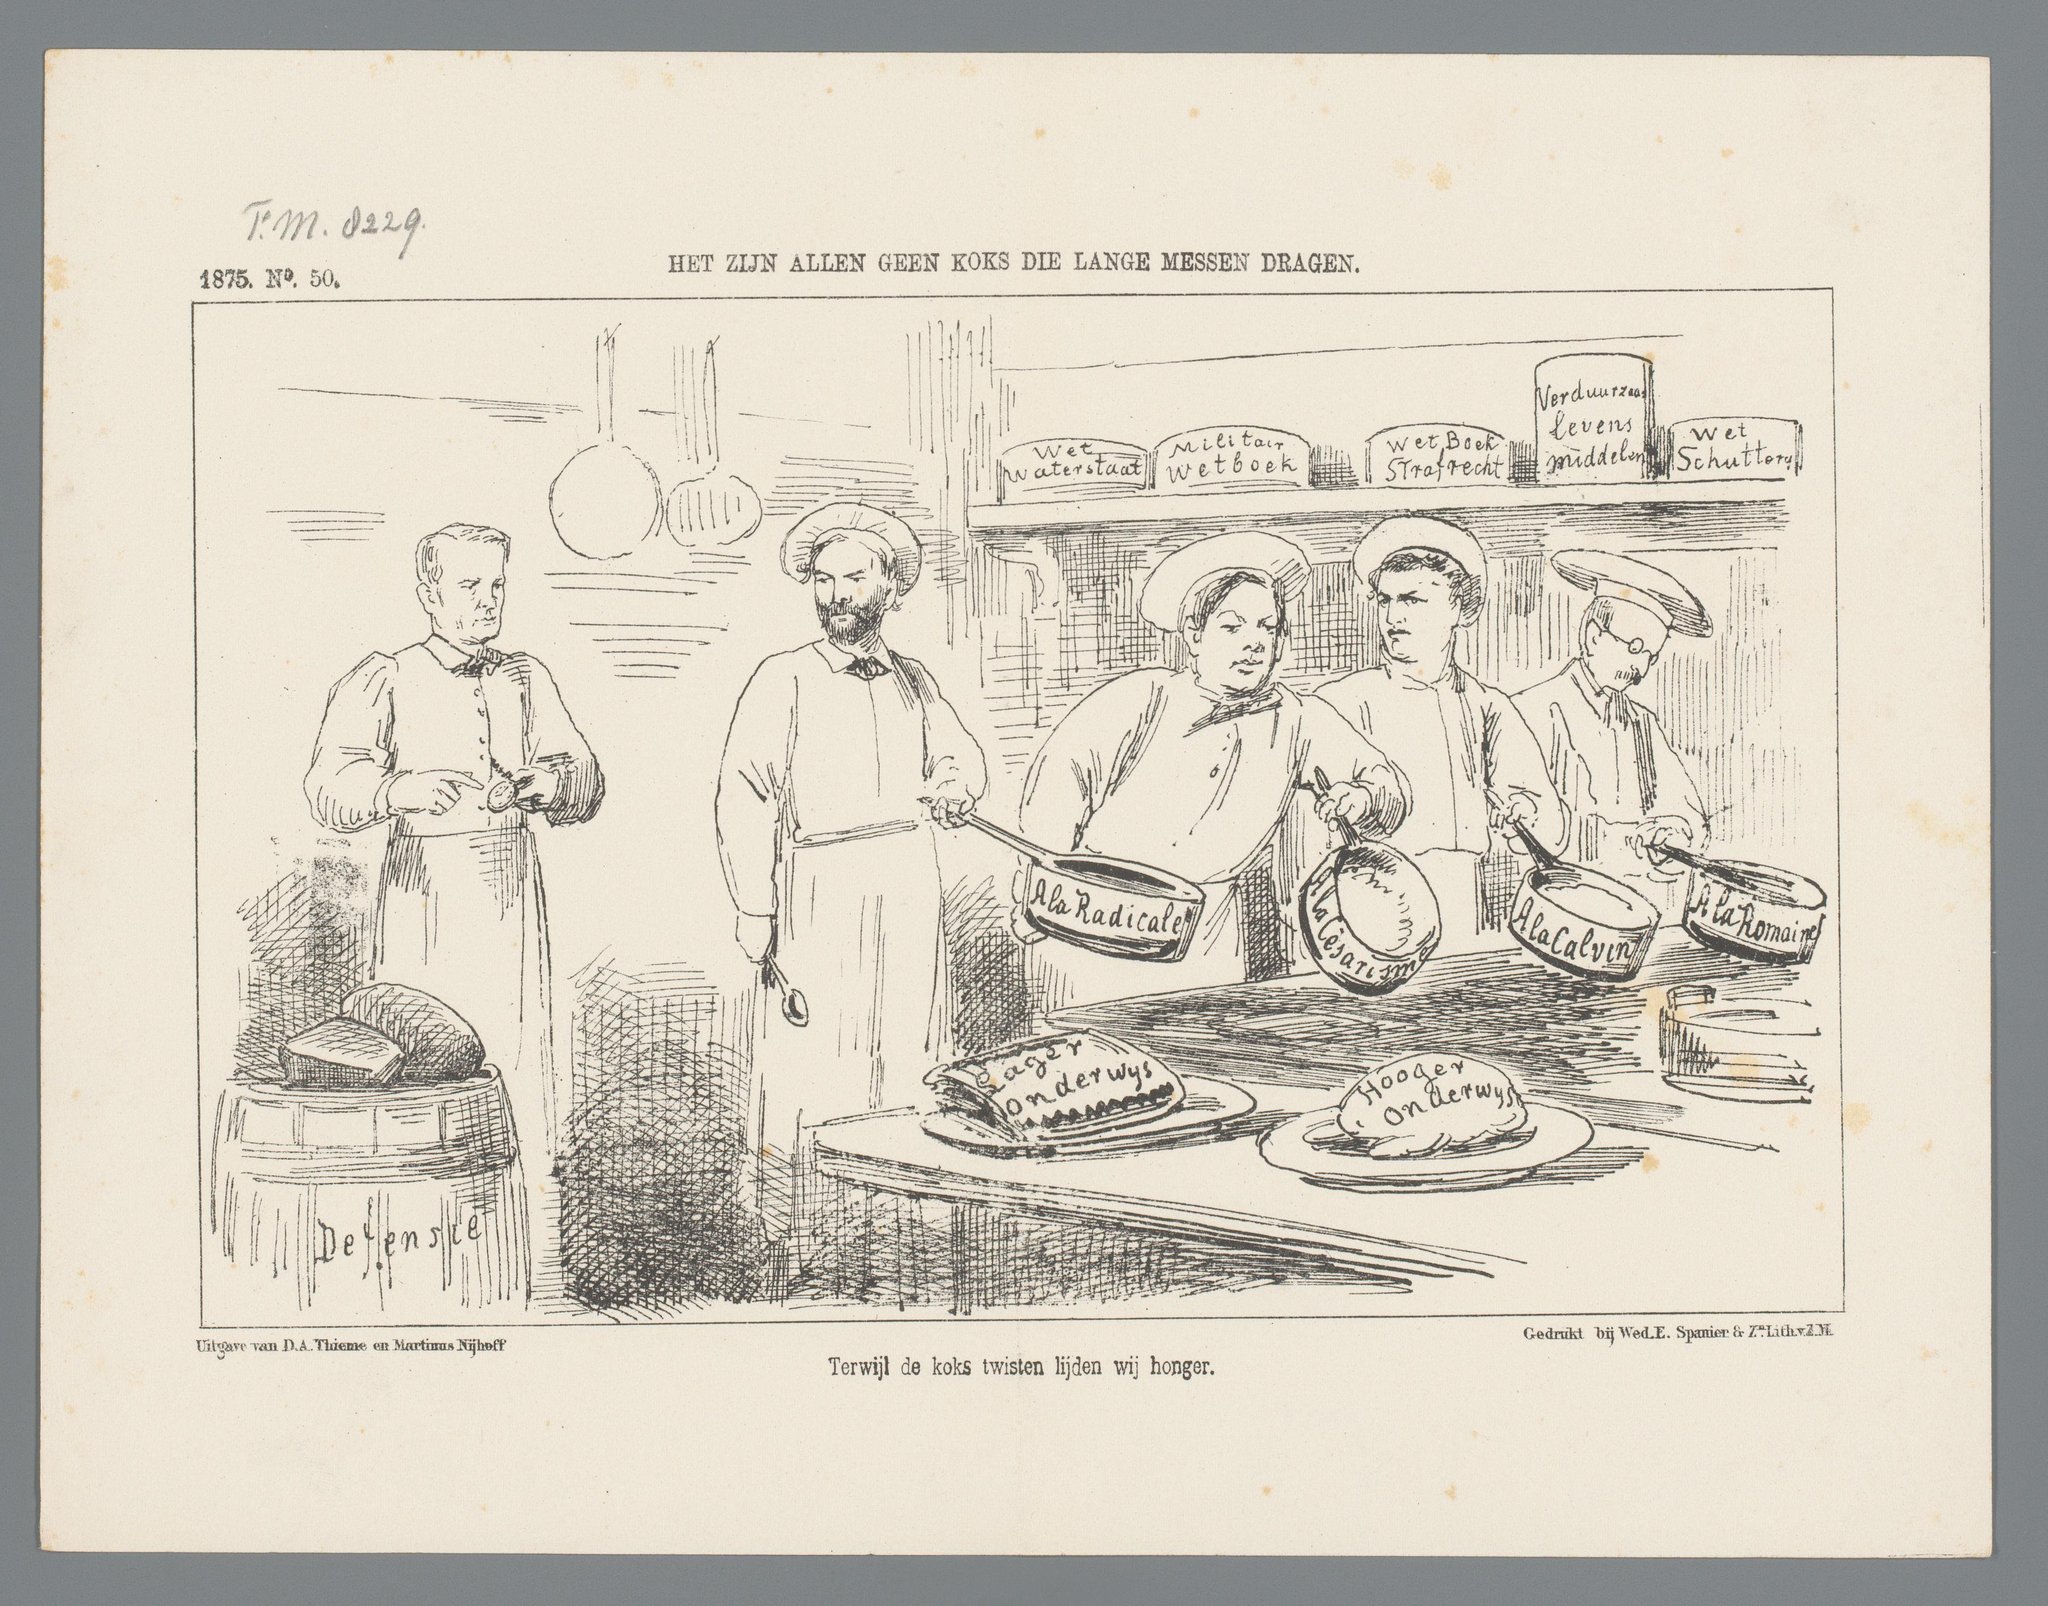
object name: cartoon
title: Spotprent op de langdurige debatten over onderwijs, 1875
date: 1875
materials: paper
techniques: lithograph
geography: netherlands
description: Spotprent op de langdurige debatten over het onderwijs. Plaat verschenen bij het weekblad De Nederlandsche Spectator, nr. 50, 1875.